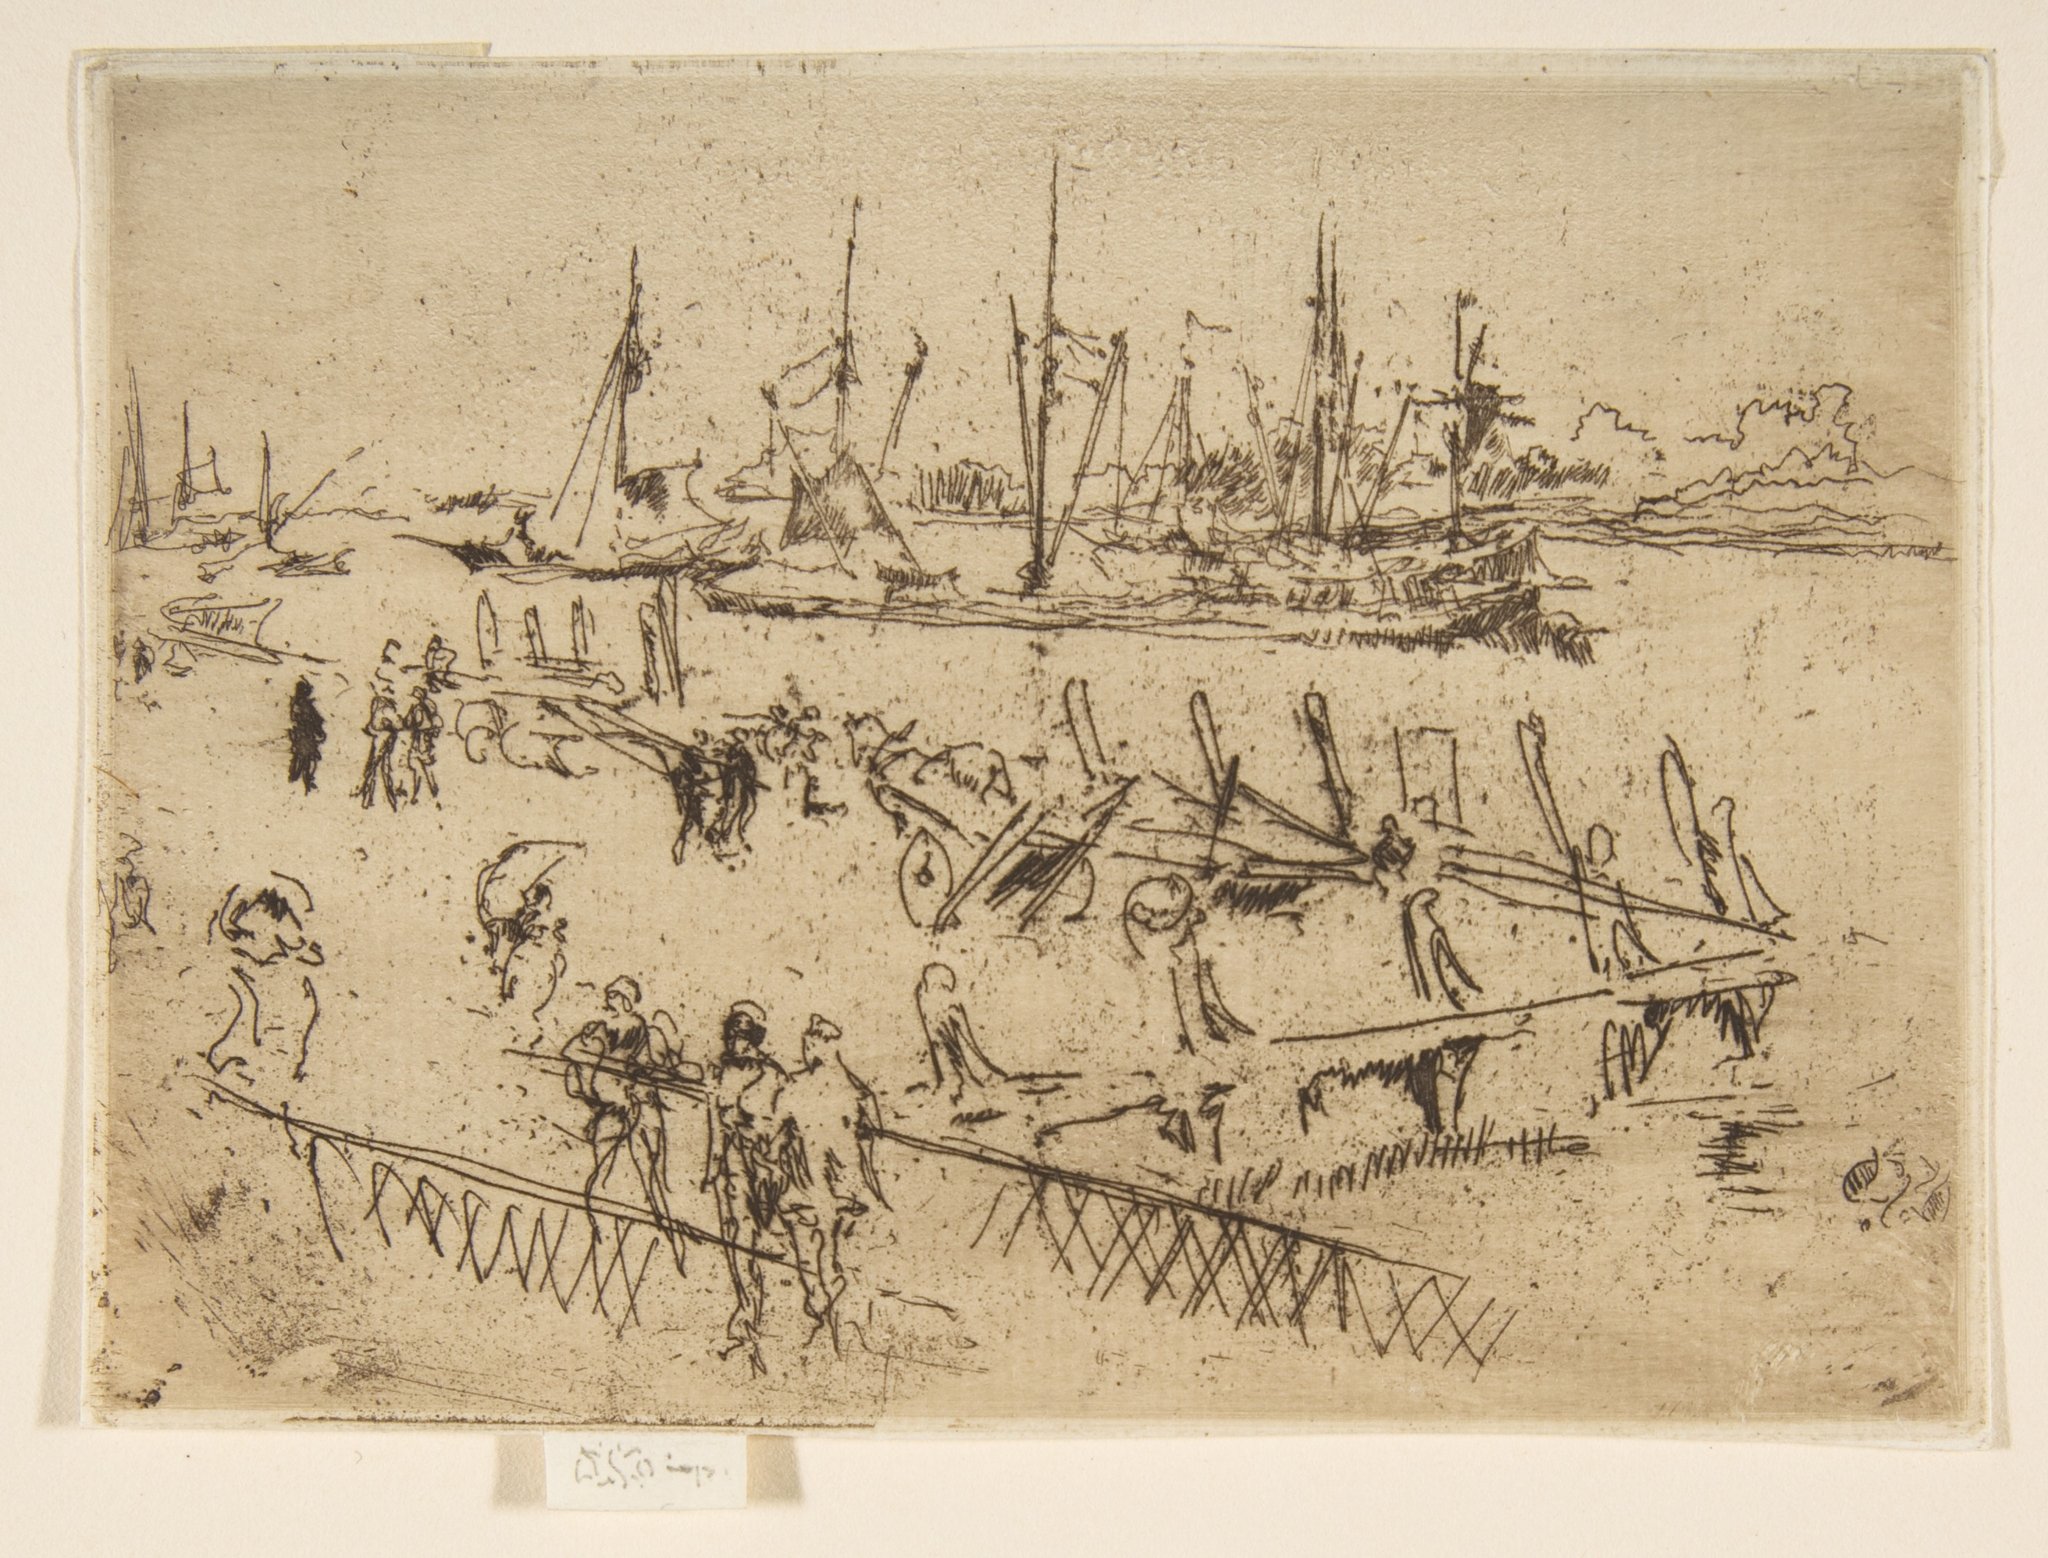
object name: print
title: Little Dordrecht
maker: james mcneill whistler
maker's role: artist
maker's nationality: american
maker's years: 1834-1903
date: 1885-1886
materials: ink, paper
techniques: etching, printing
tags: working,ships